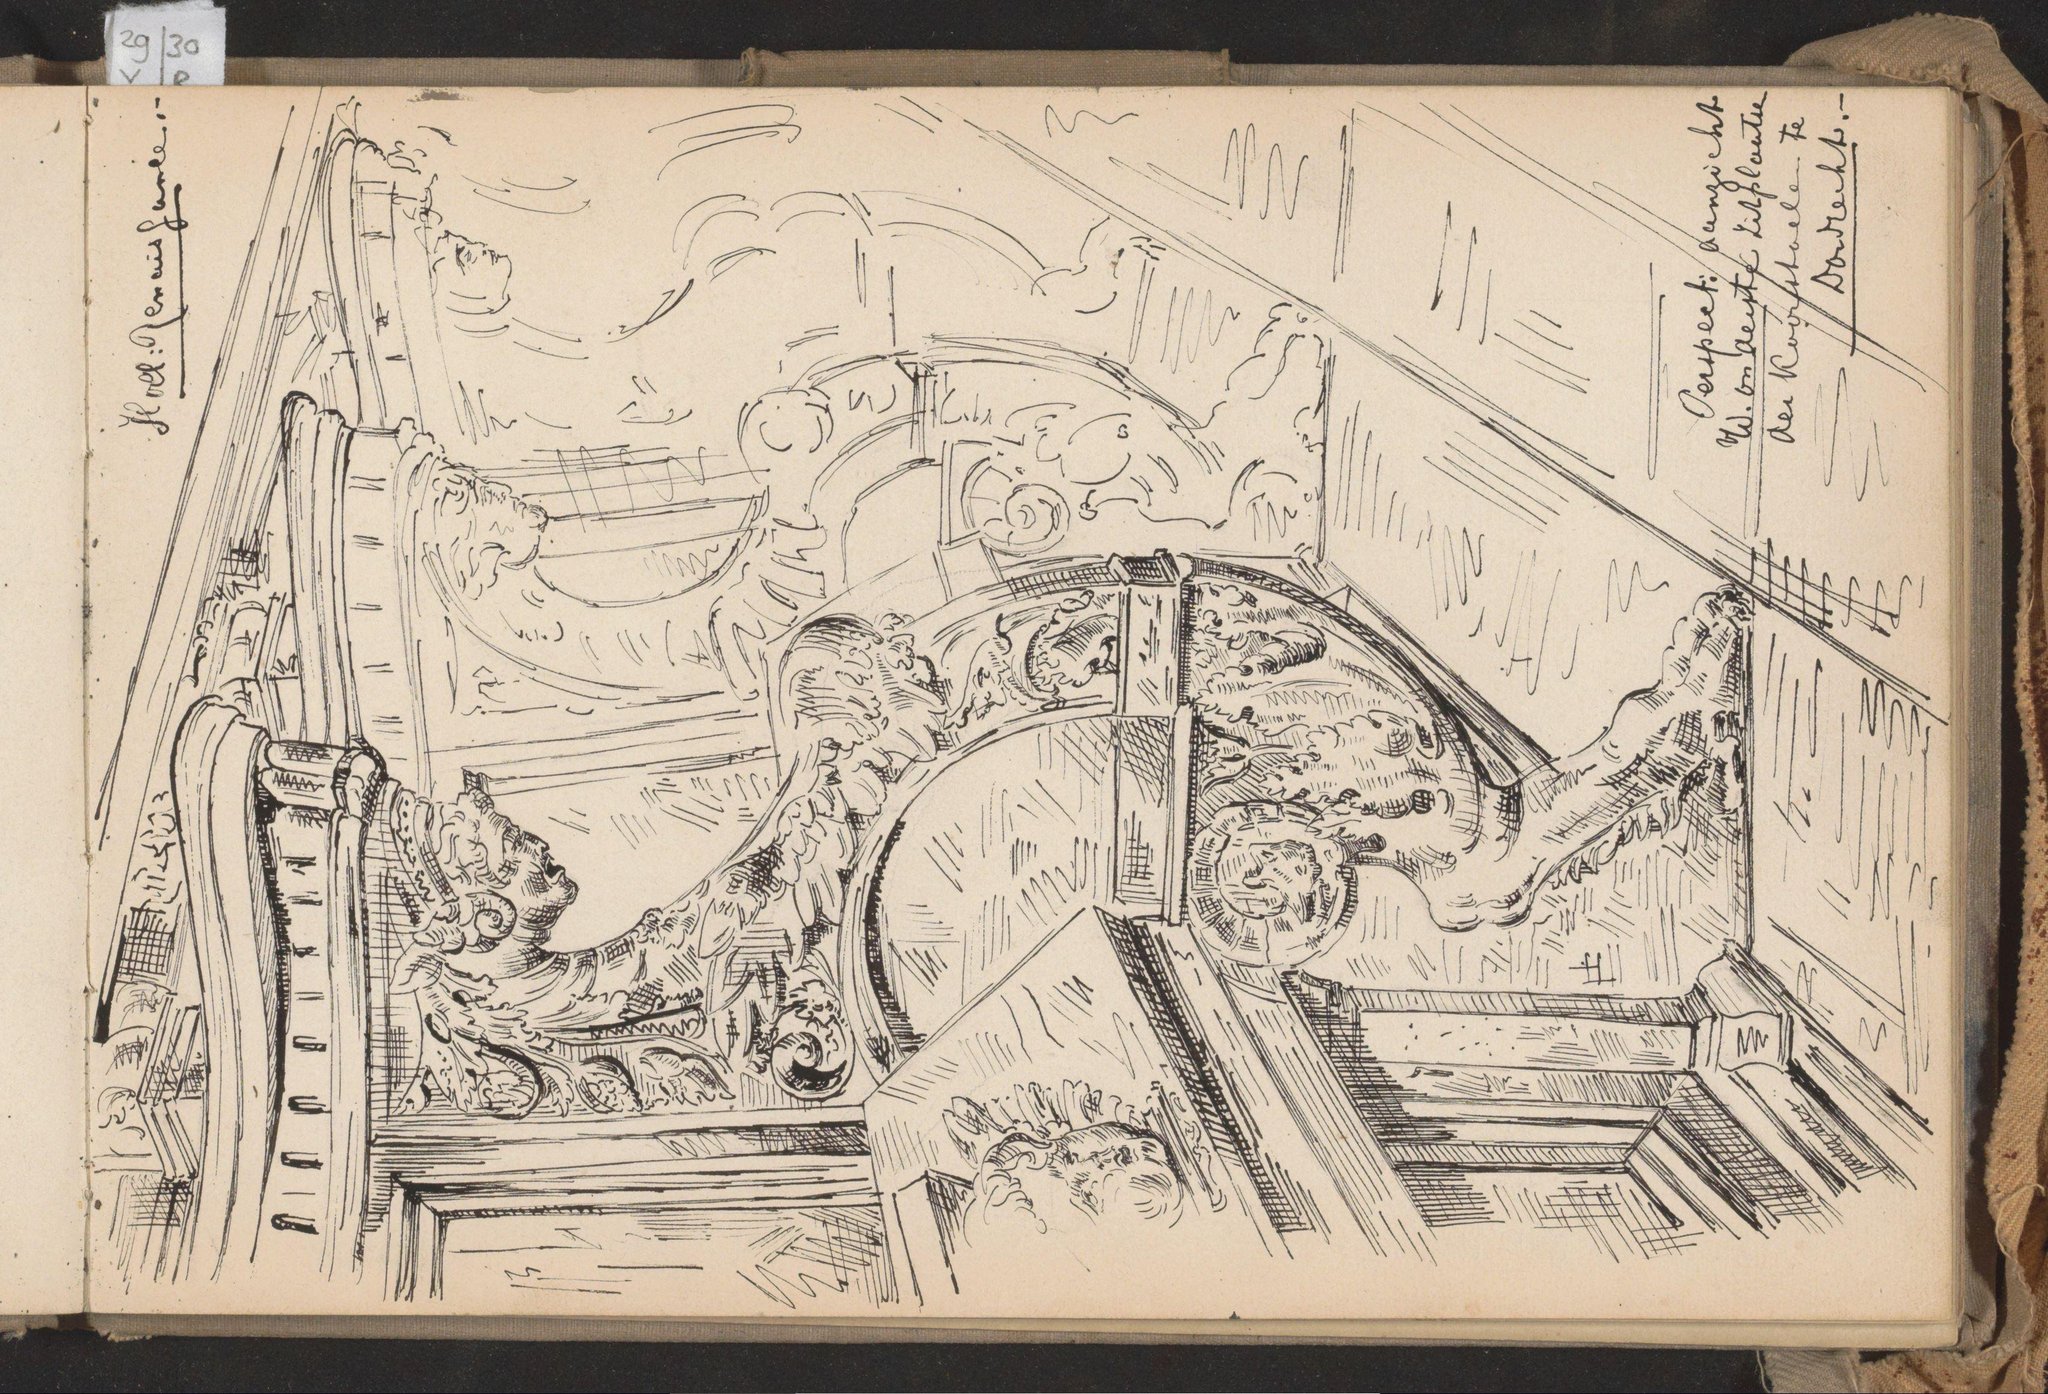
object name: sketchbook leaf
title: Koorstoelen van de Grote Kerk te Dordrecht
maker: johanna van de kamer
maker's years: 1873-1922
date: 1890-1922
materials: ink, paper, pencil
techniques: pen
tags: carving ~ applied arts, seats of the clergy, choir-stalls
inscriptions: annotation: ‘Perspect: aangezicht/ v/d onderste zitbanken/ der koorstoelen te/ Dordrecht.-’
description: Gezicht op het houtsnijwerk. Blad 25 recto uit een schetsboek met 49 bladen.